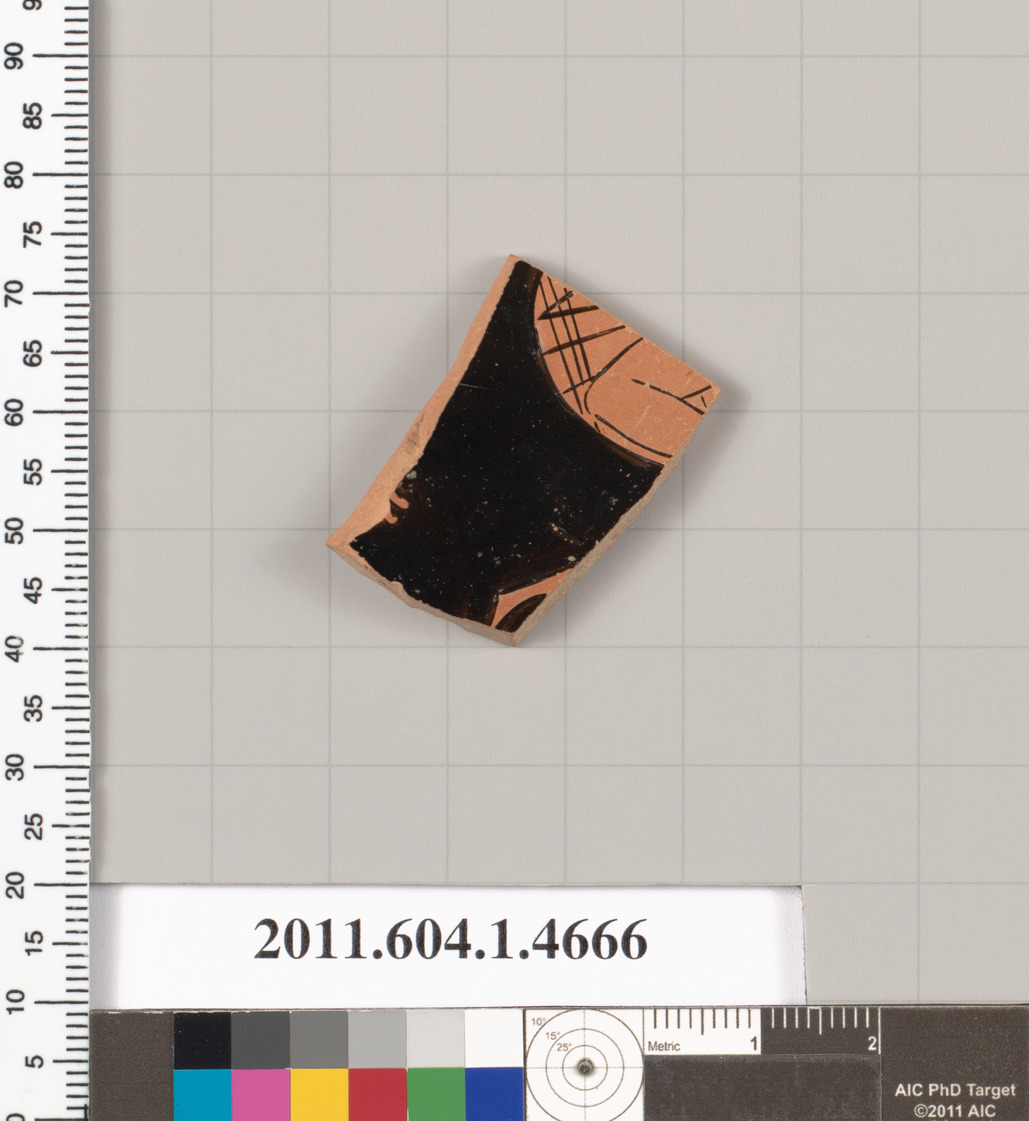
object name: kylix fragment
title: Terracotta fragment of a kylix (drinking cup)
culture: greek, attic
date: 490-470 BCE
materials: terracotta